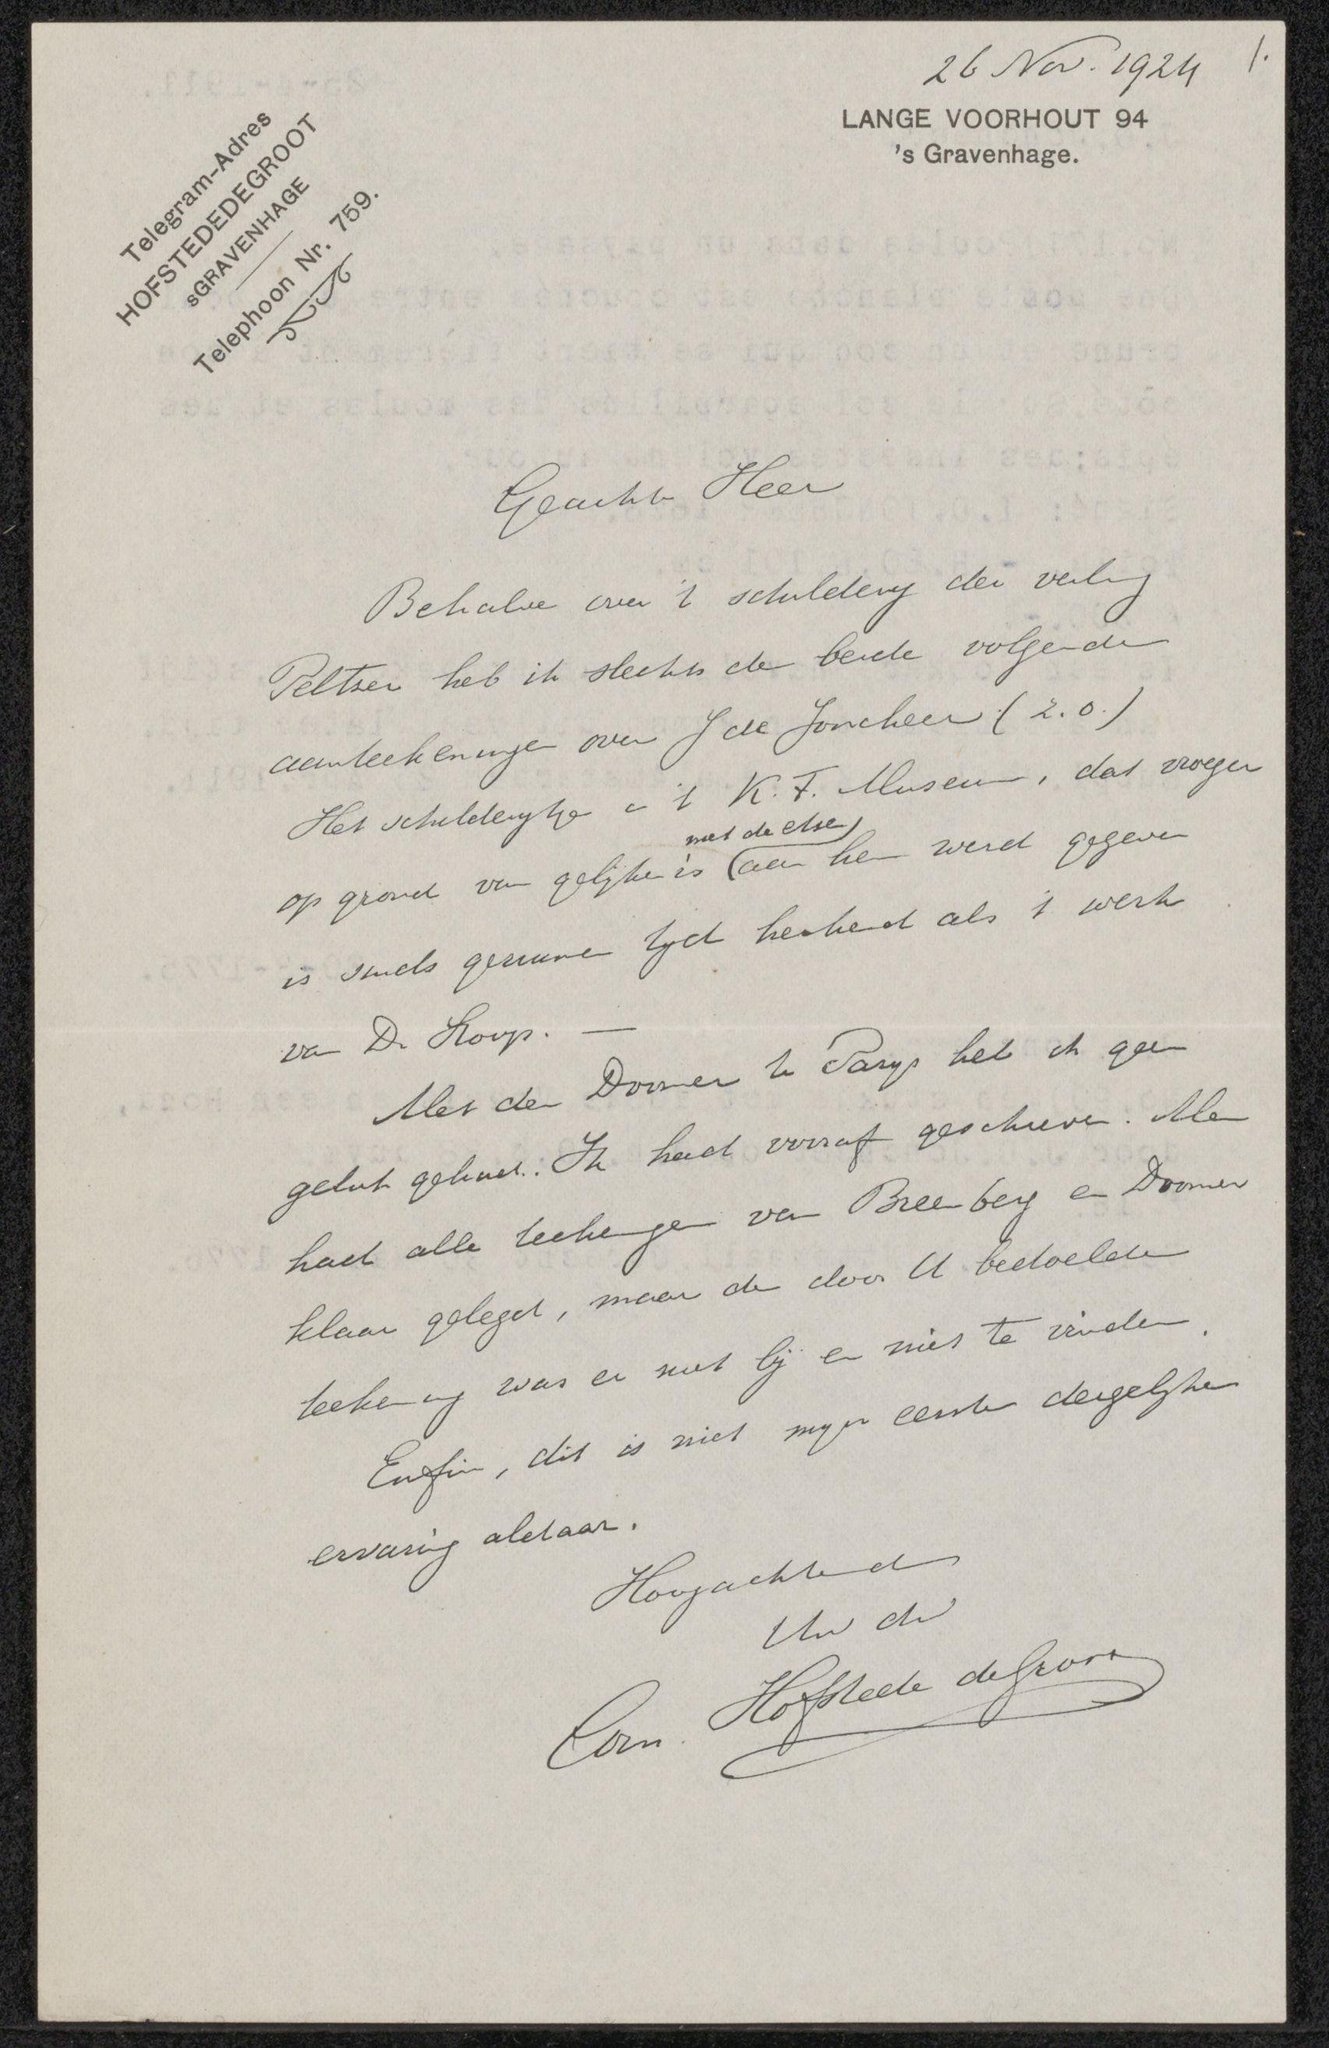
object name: letter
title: Brief aan Max Dittmar Henkel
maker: cornelis hofstede de groot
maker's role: kunsthistoricus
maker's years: 1863-1940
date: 1924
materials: ink, paper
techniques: pen, printing, typewriting, writing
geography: the hague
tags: deventer, print maker, draughtsman, bartholomeus breenbergh, utrecht, jacob de jonckheer, lambert doomer, max dittmar henkel, drawing, painting (including book-illumination, miniature-painting)